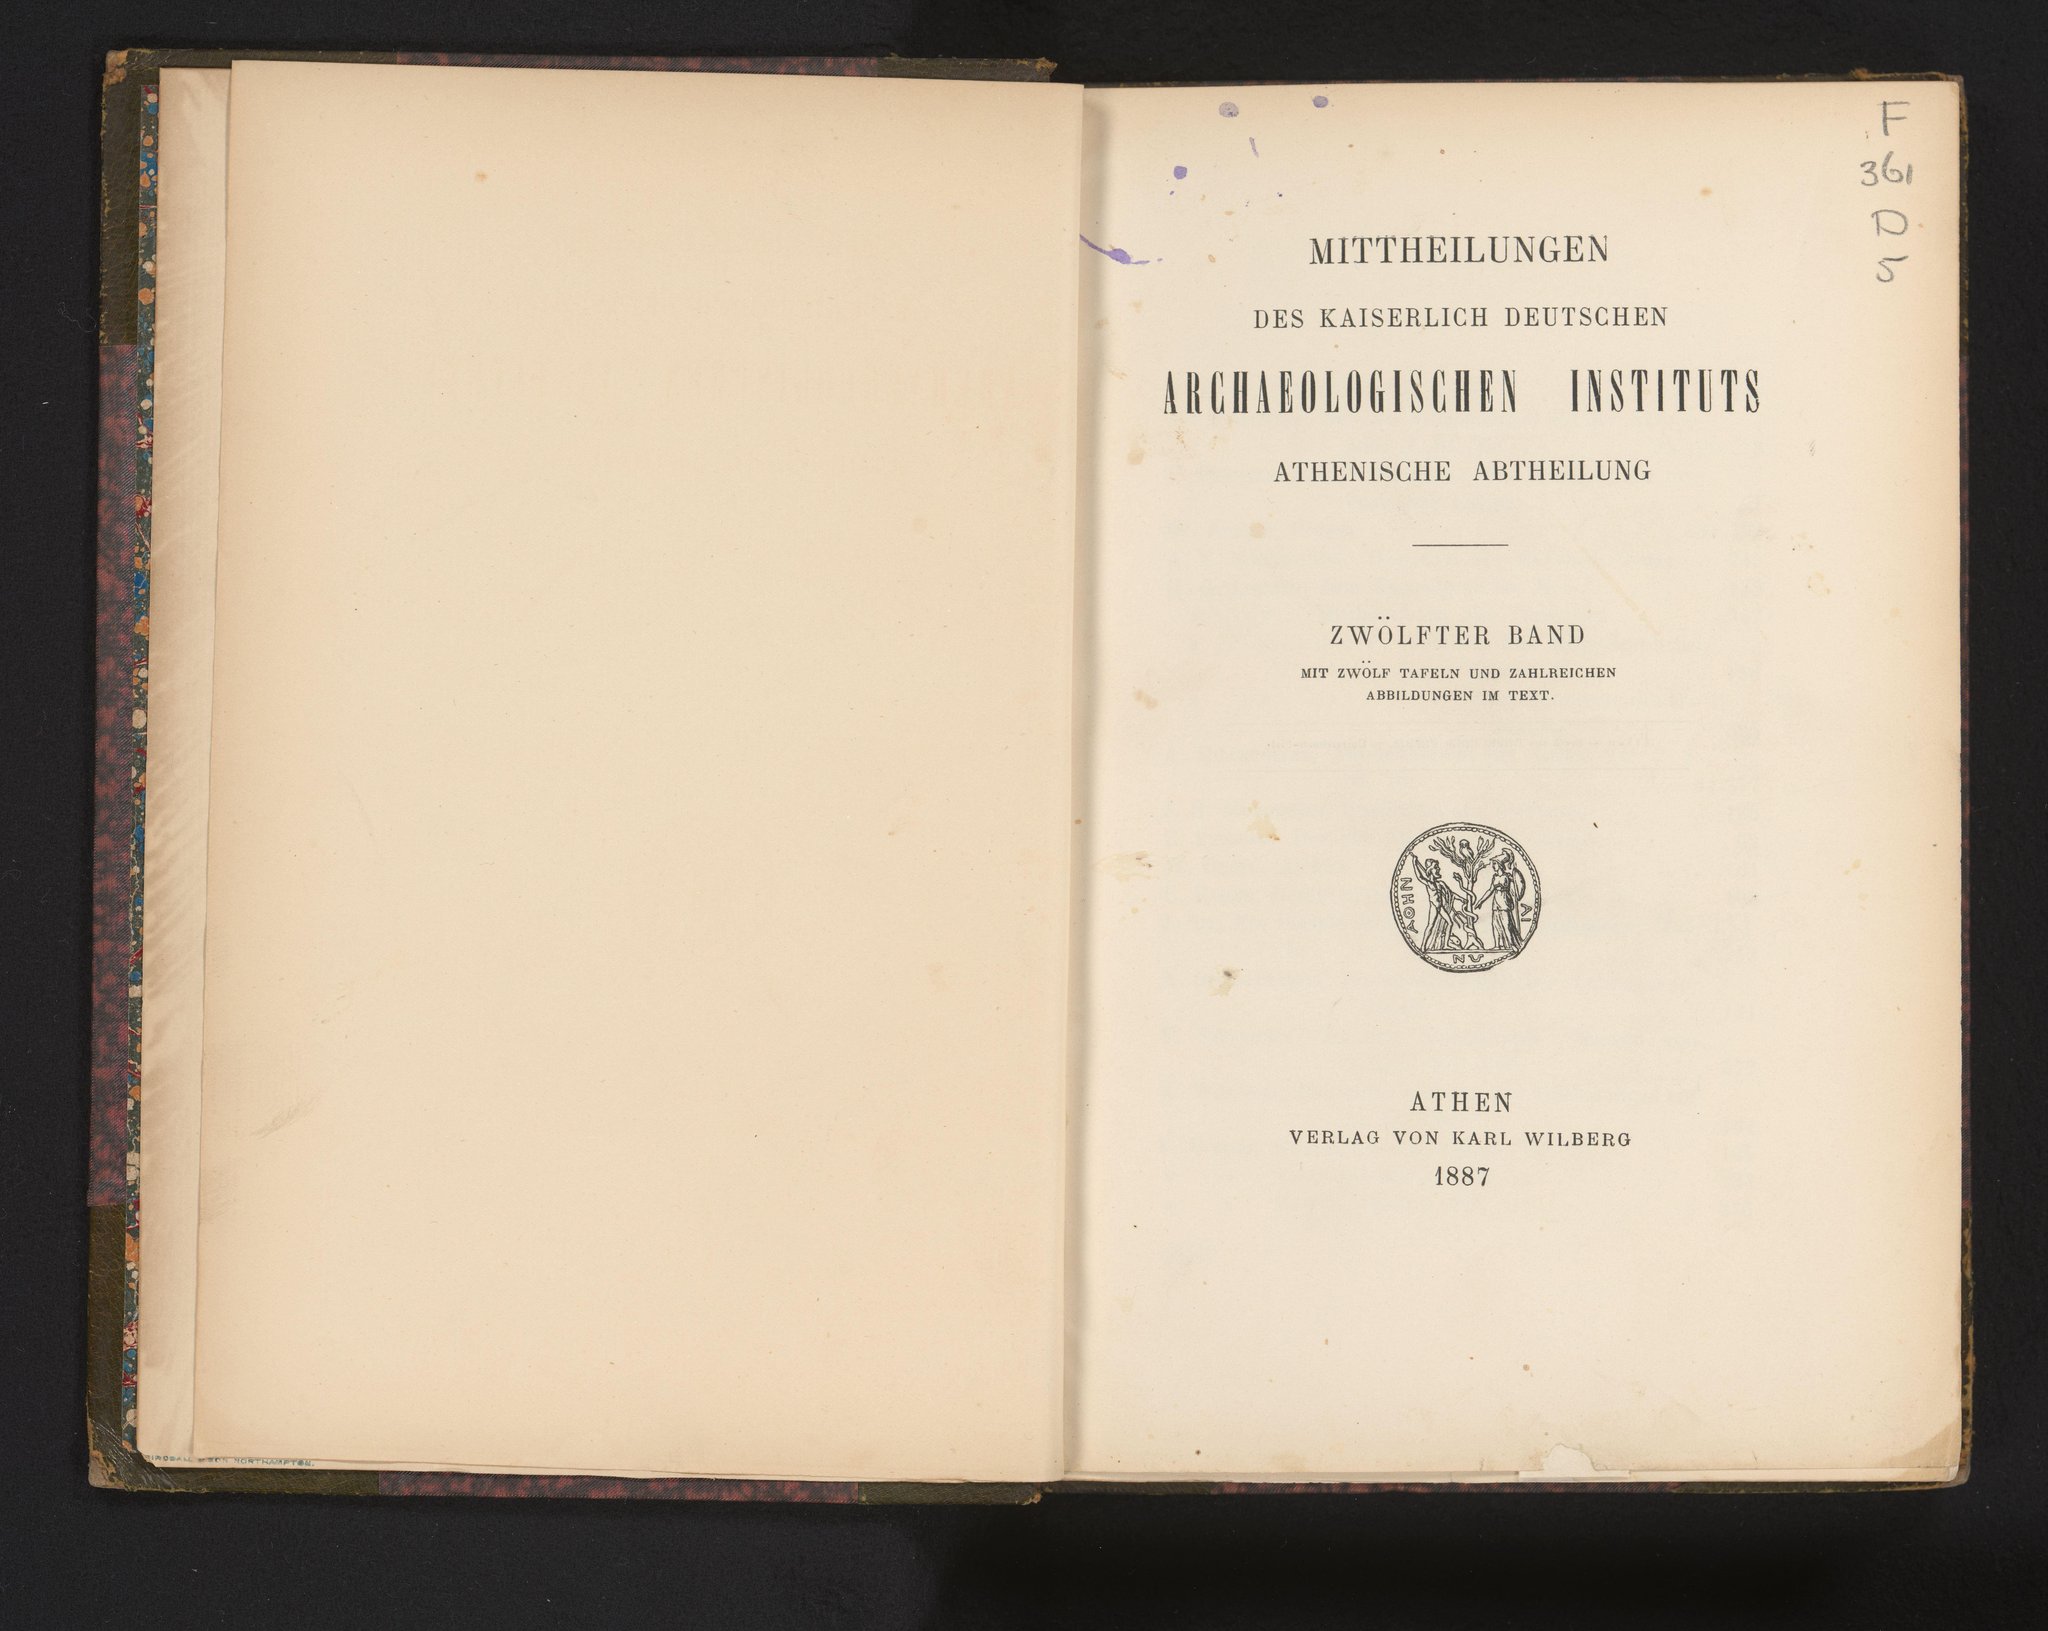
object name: book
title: Mittheilungen des Kaiserlich Deutschen Archaeologischen Instituts. Athenische Abtheilung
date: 1886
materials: cardboard, paper, textile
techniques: photograph, printing, marbling